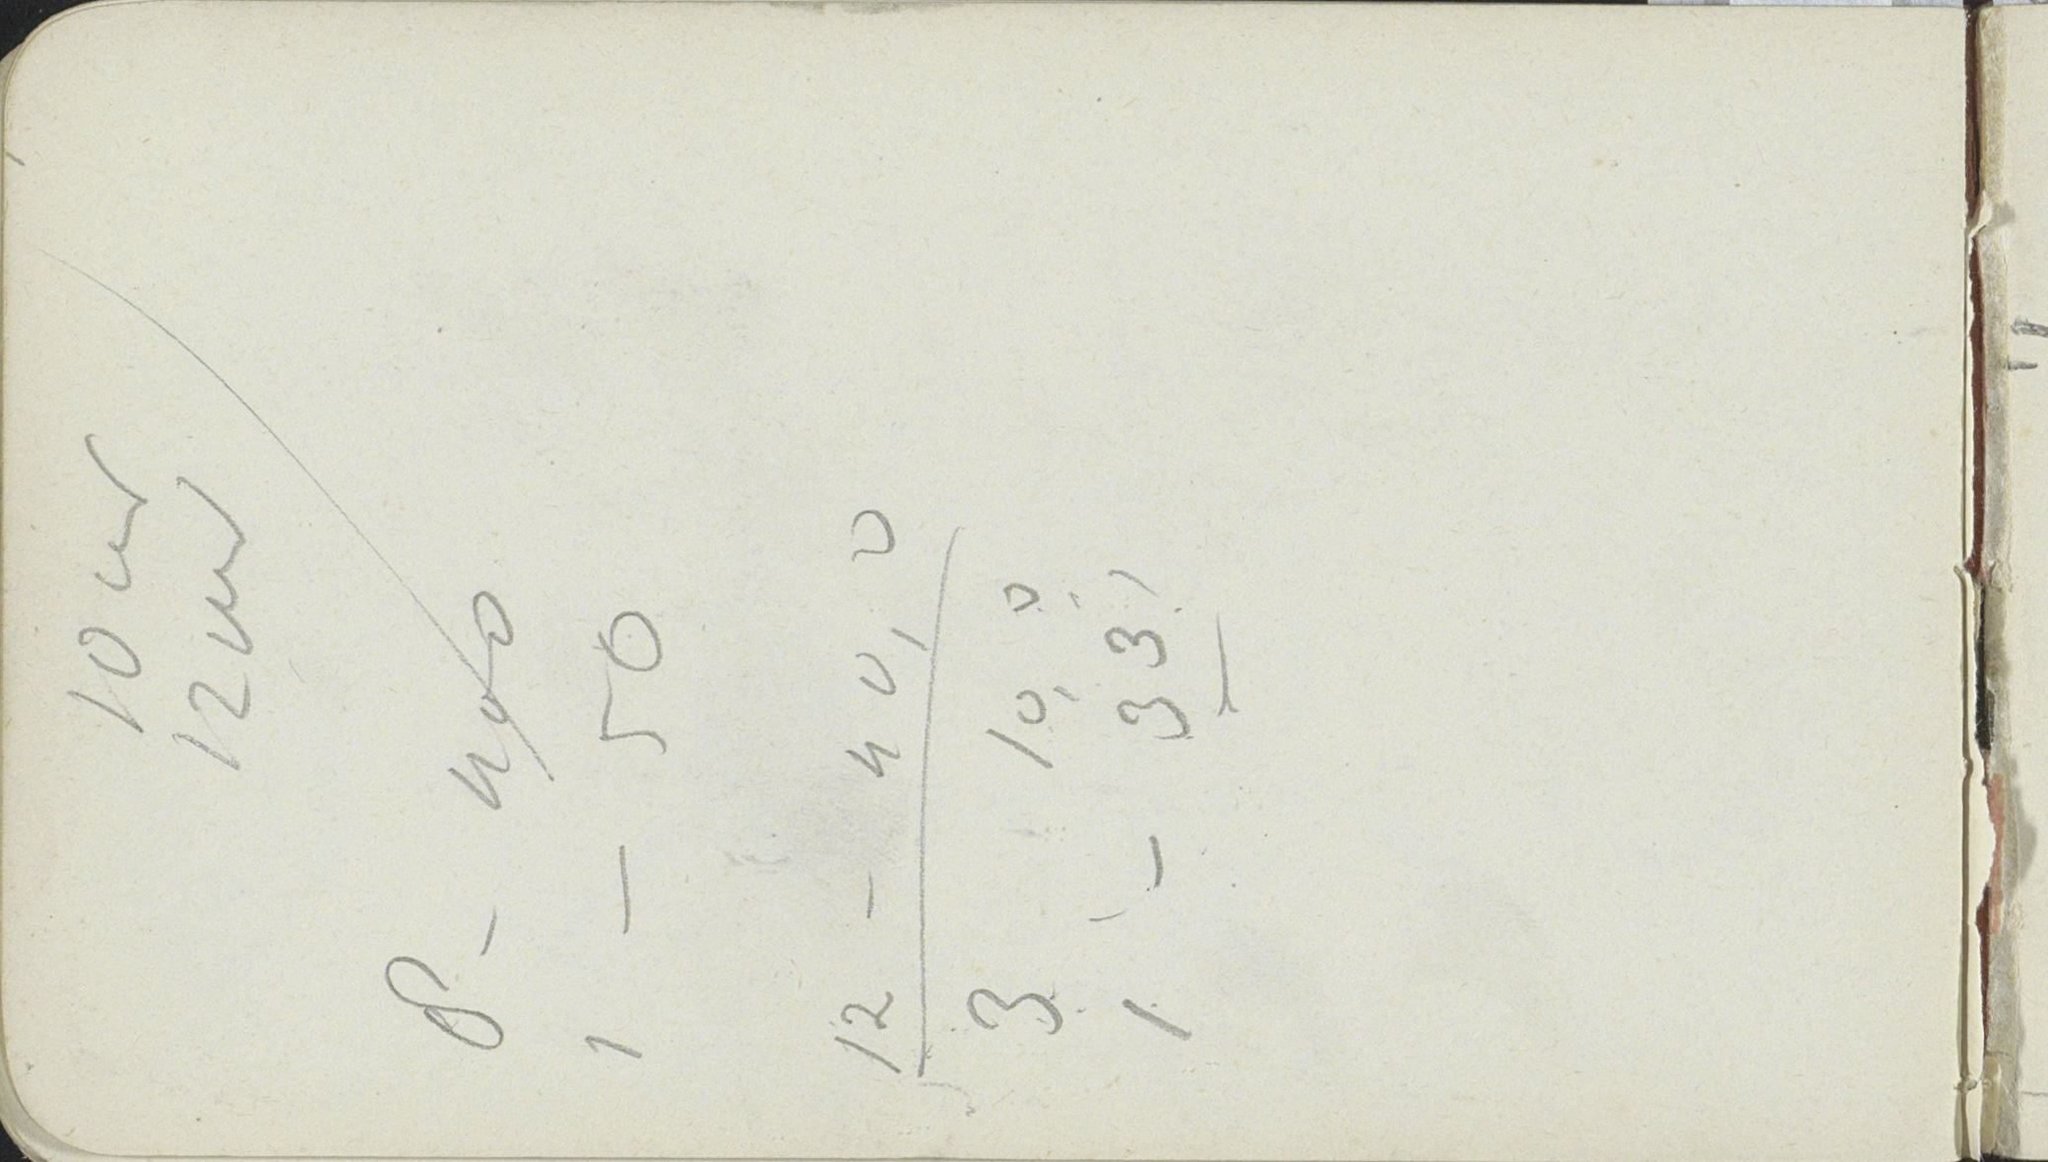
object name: sketchbook leaf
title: Berekeningen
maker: carel adolph lion cachet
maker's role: draughtsman, print maker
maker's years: 1864-1945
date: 1905-1906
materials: paper, pencil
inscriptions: annotation: ‘10 uur/ 12 uur/ [...]’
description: Blad 17 verso uit een schetsboek met 34 bladen.